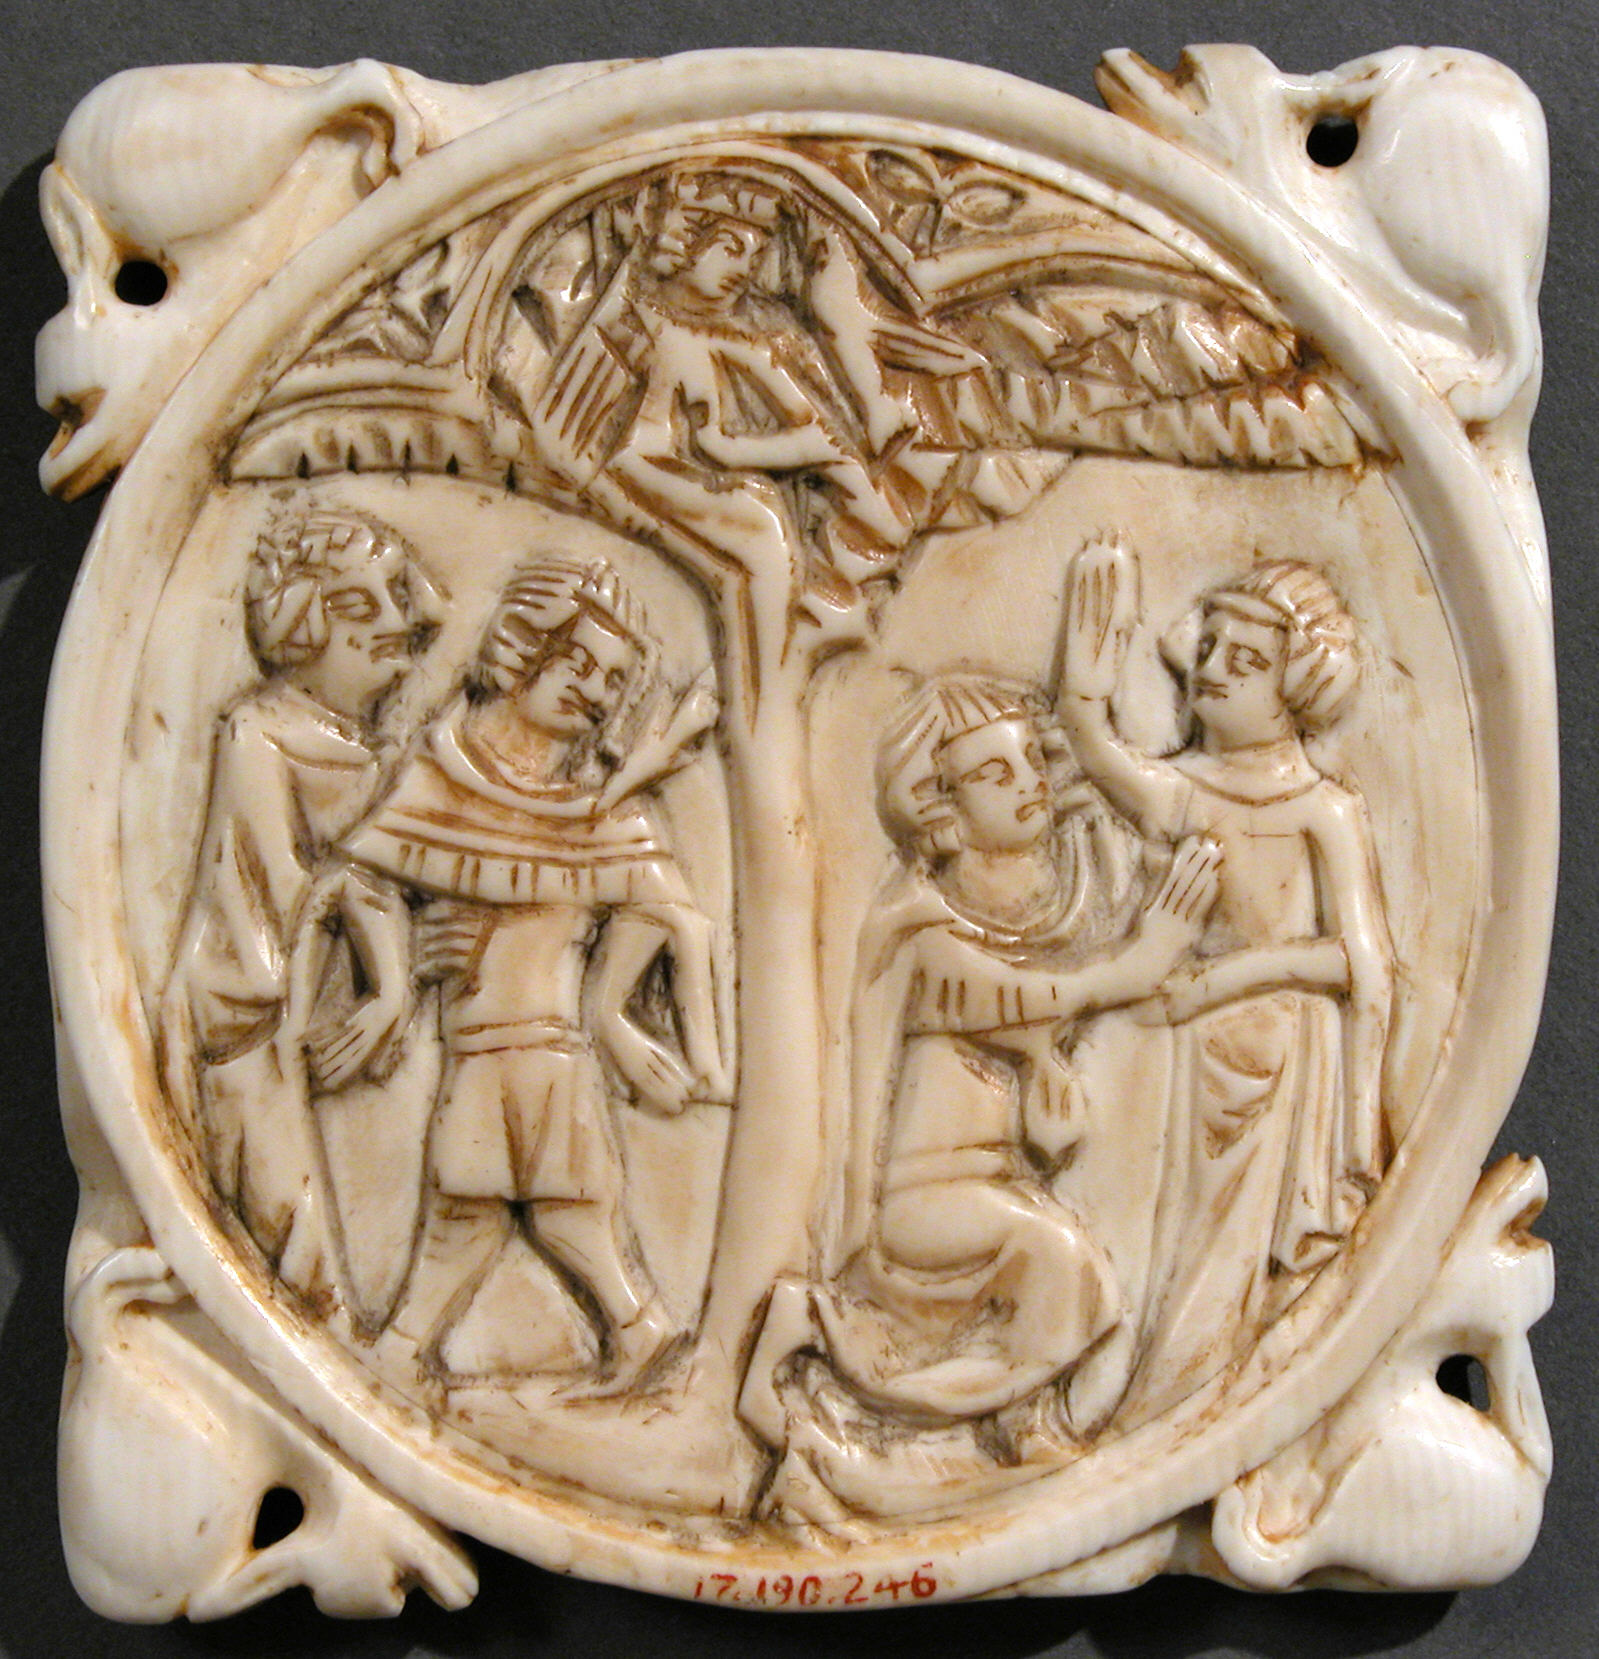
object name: mirror case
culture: french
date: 1350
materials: ivory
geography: france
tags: men